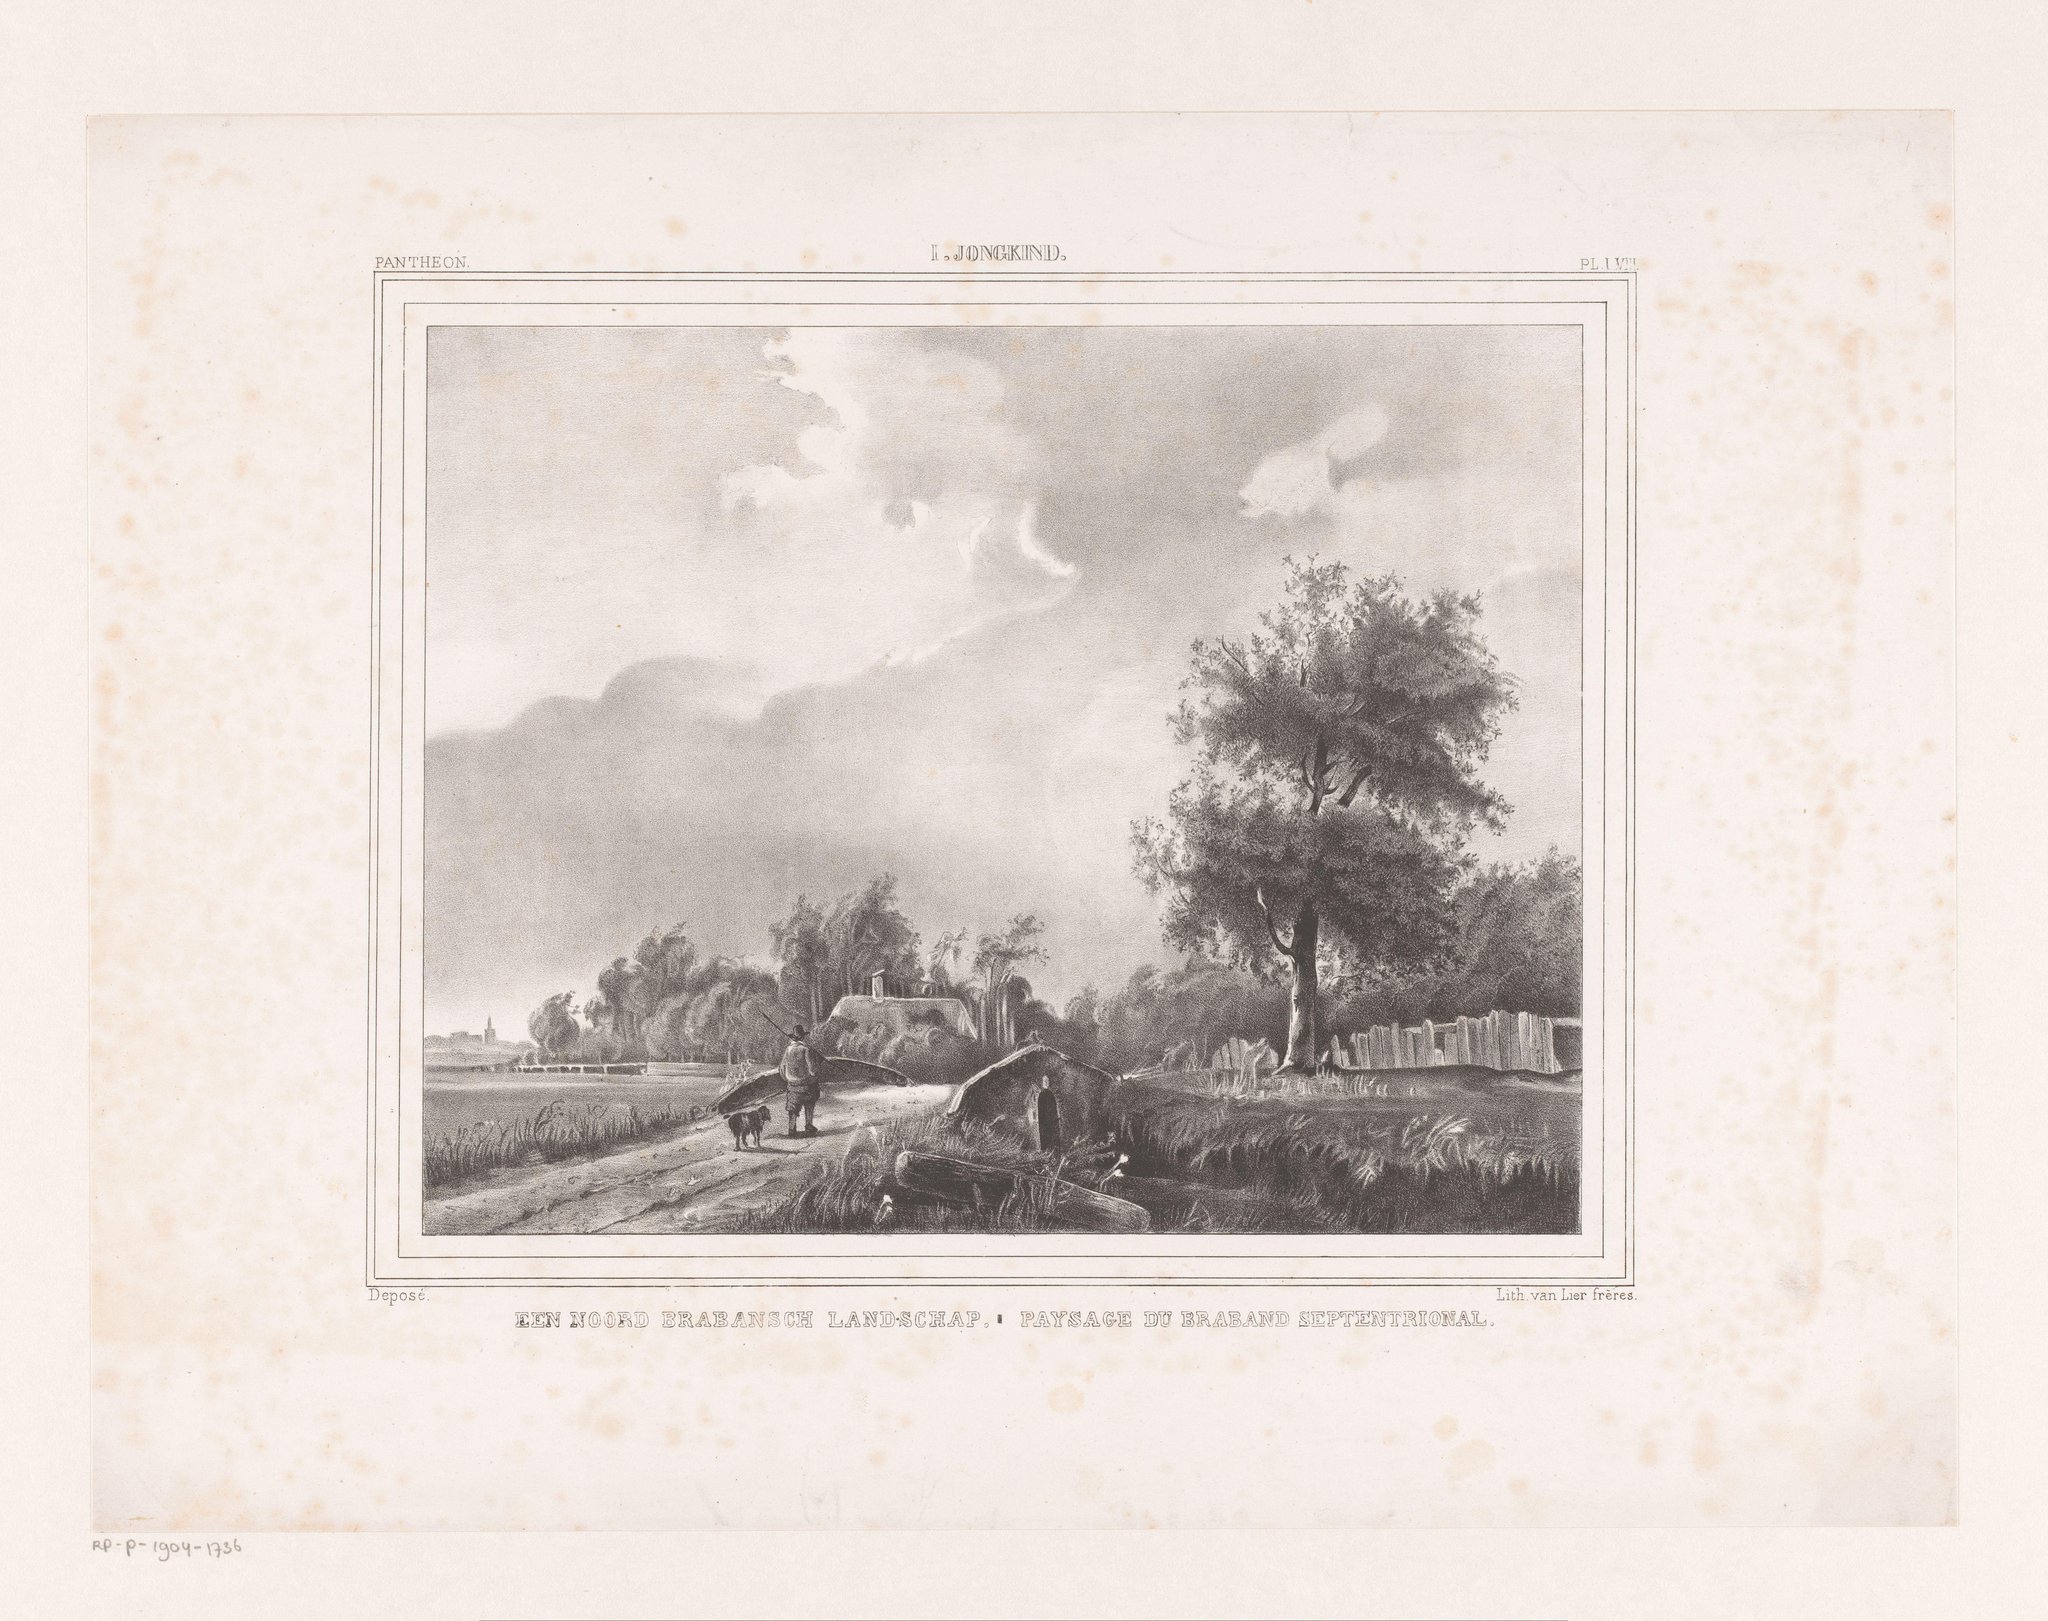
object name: print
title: Een Noord Brabansch landschap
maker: johan barthold jongkind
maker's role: draughtsman, painter, print maker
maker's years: 1819-1891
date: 1837-1843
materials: paper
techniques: lithograph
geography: the hague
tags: landscape with bridge, viaduct or aqueduct, farm or solitary house in landscape, dog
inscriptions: : ‘Deposé’, collector's mark: Lugt 2228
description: Deze prent maakte mogelijk deel uit van: Pantheon of de tempel der onsterfelijkheid van Nederlandse kunstschilders. Uitgegeven door Gebroeders Van Lier in Amsterdam tussen 1837 en (in ieder geval) 1843.